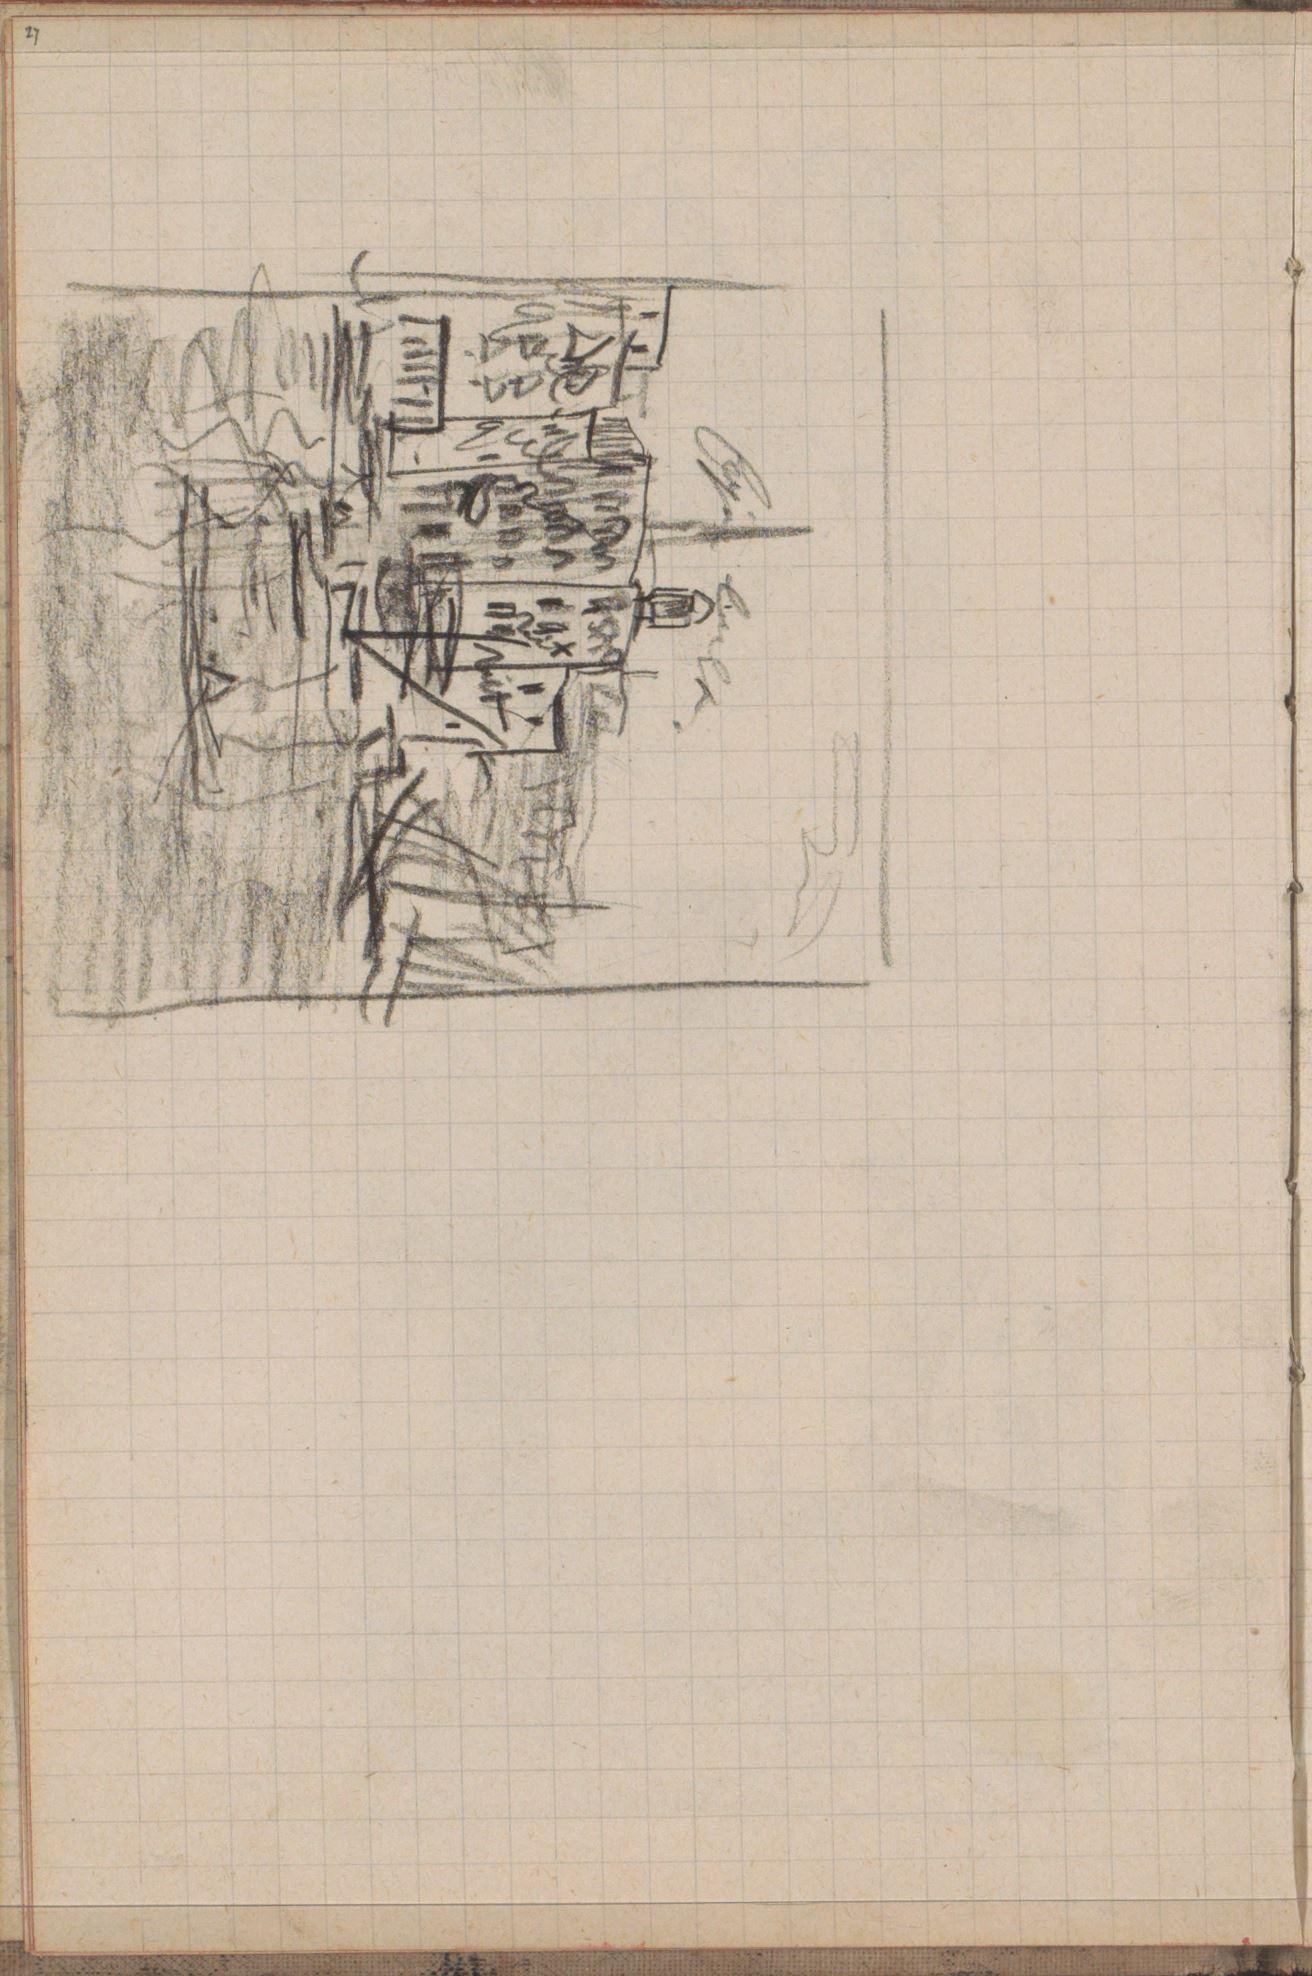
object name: sketchbook leaf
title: Haven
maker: marius bauer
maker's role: draughtsman, print maker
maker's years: 1867-1932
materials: chalk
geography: istanbul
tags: harbour, architecture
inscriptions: kleurnotitie, handgeschreven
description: Vermoedelijk de haven van Constantinopel. Pagina 27 uit een schetsboek met 54 bladen.